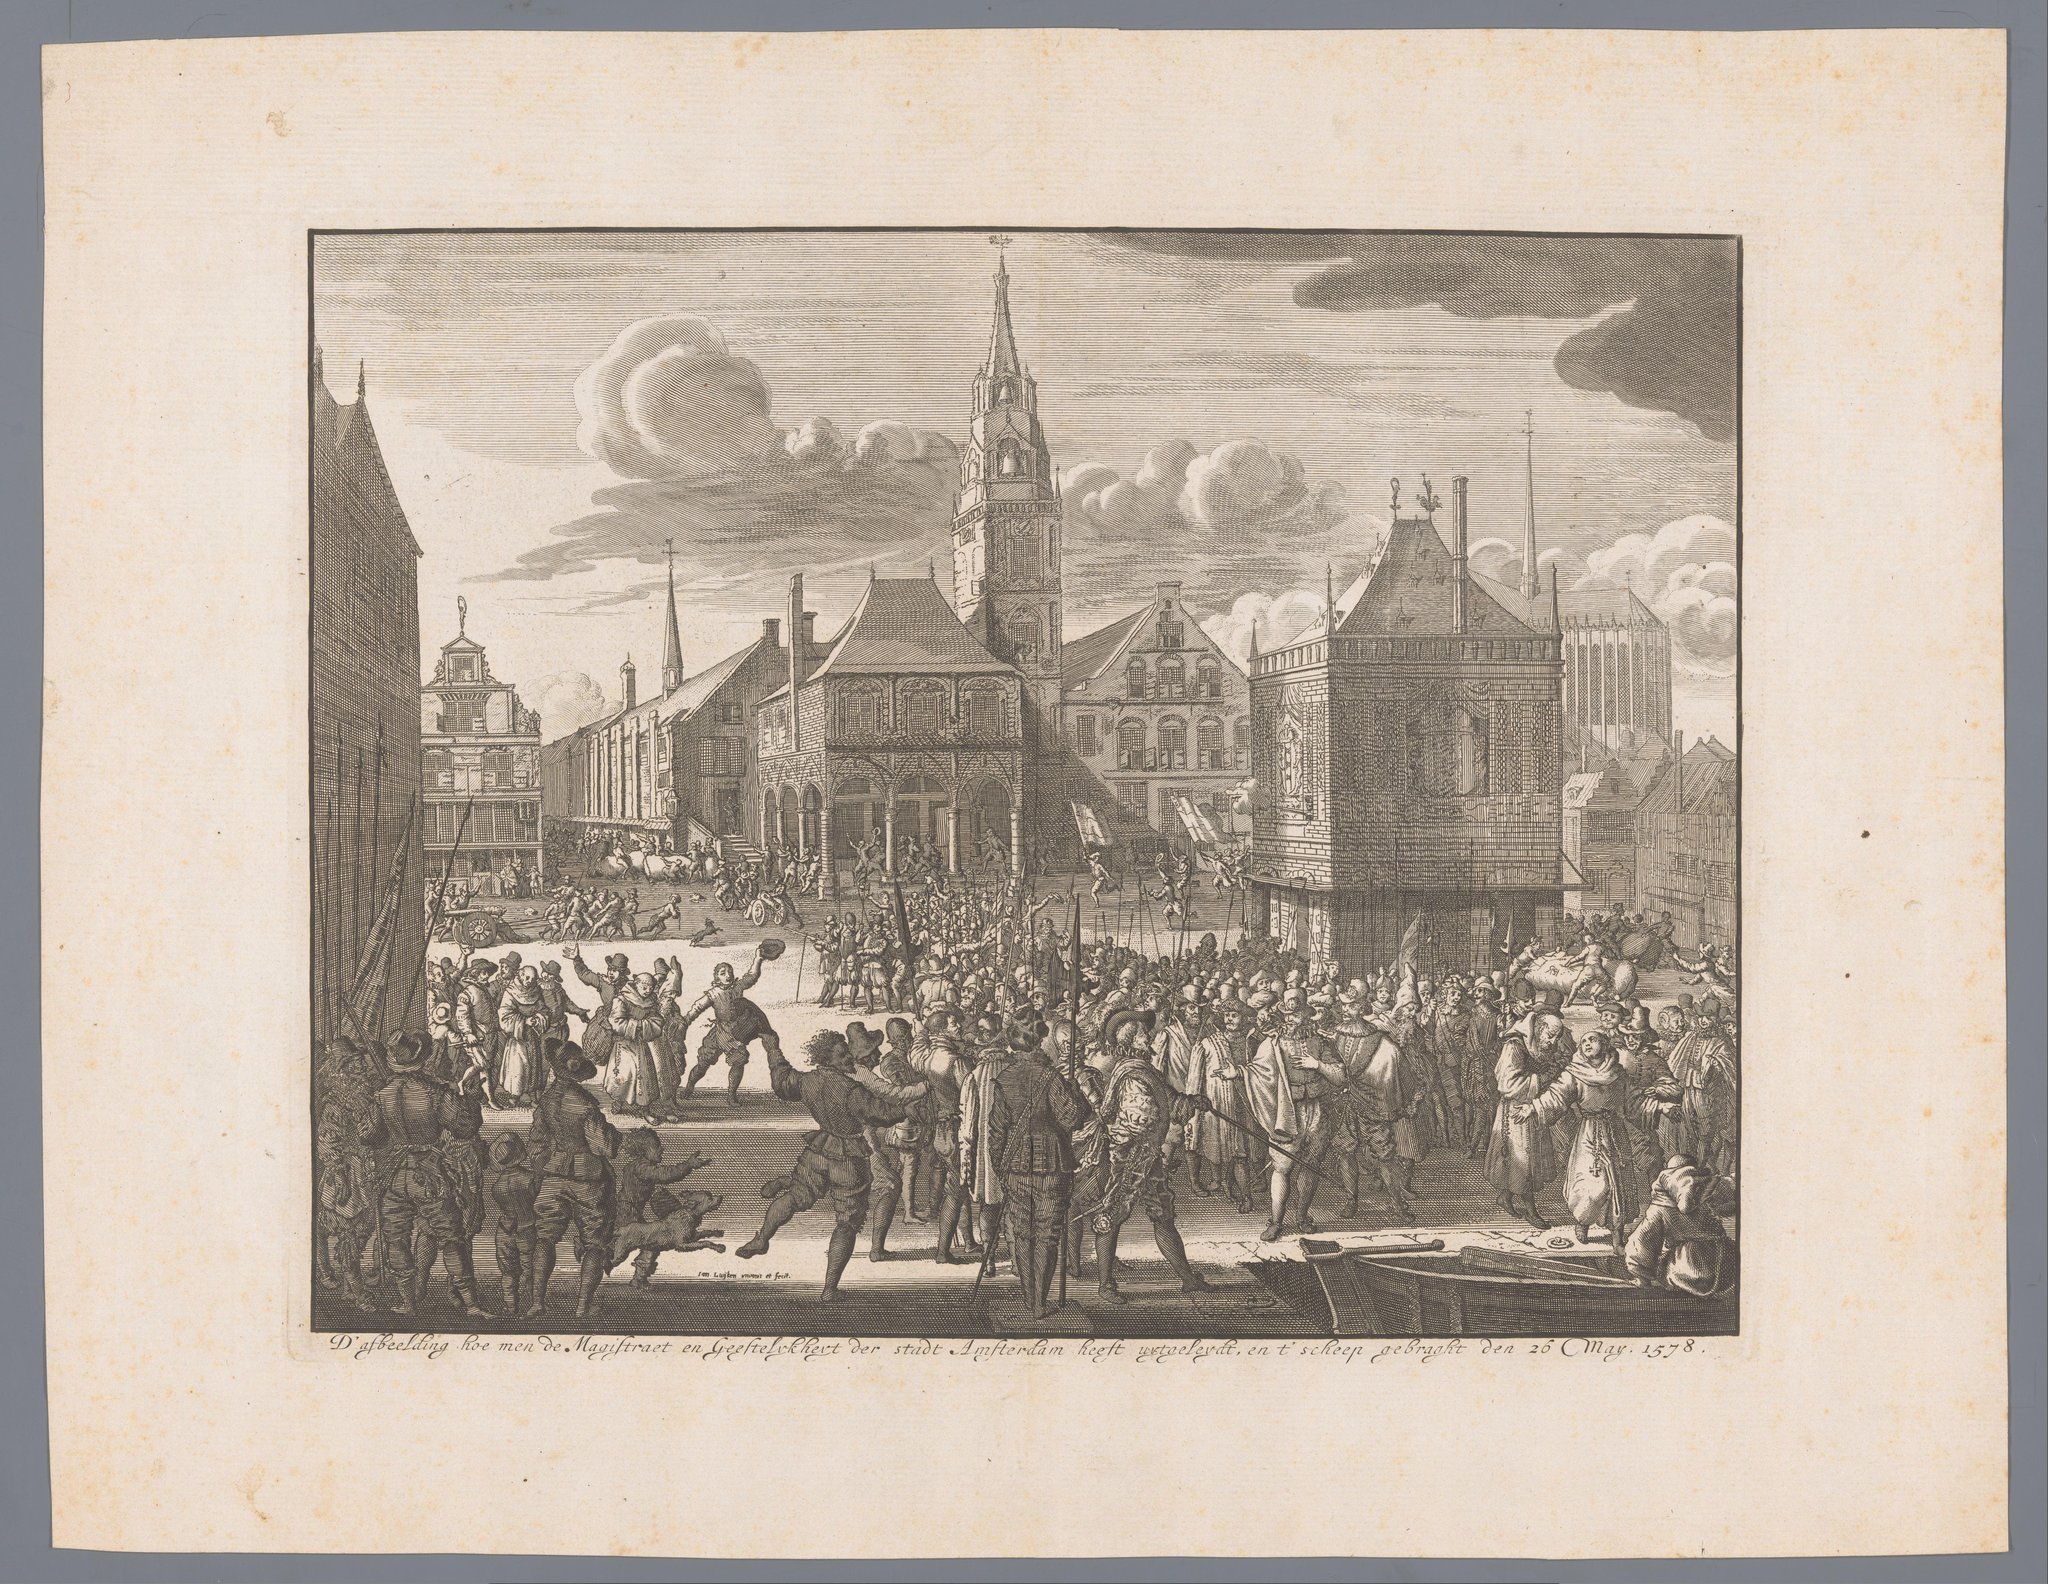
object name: print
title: Alteratie van Amsterdam, 26 mei 1578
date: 1726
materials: paper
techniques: engraving, etching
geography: amsterdam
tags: church (exterior), townhall, weigh-house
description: Prent uit: Commelin, Caspar. Beschryvinge van Amsterdam, zynde een naukeurige verhandelinge van desselfs eerste oorspronk uyt (…). Amsterdam: Andries van Damme et al., 1726, dl. 2. Prent in eerdere staten gebruikt in eerdere uitgaven van dit werk in 1693 en 1694 en in: Bor Christiaansz, Pieter. Oorsprongk, begin, en vervolgh der Nederlandsche oorlogen (...). Amsterdam: Weduwe Joannes van Someren et al., 1679.